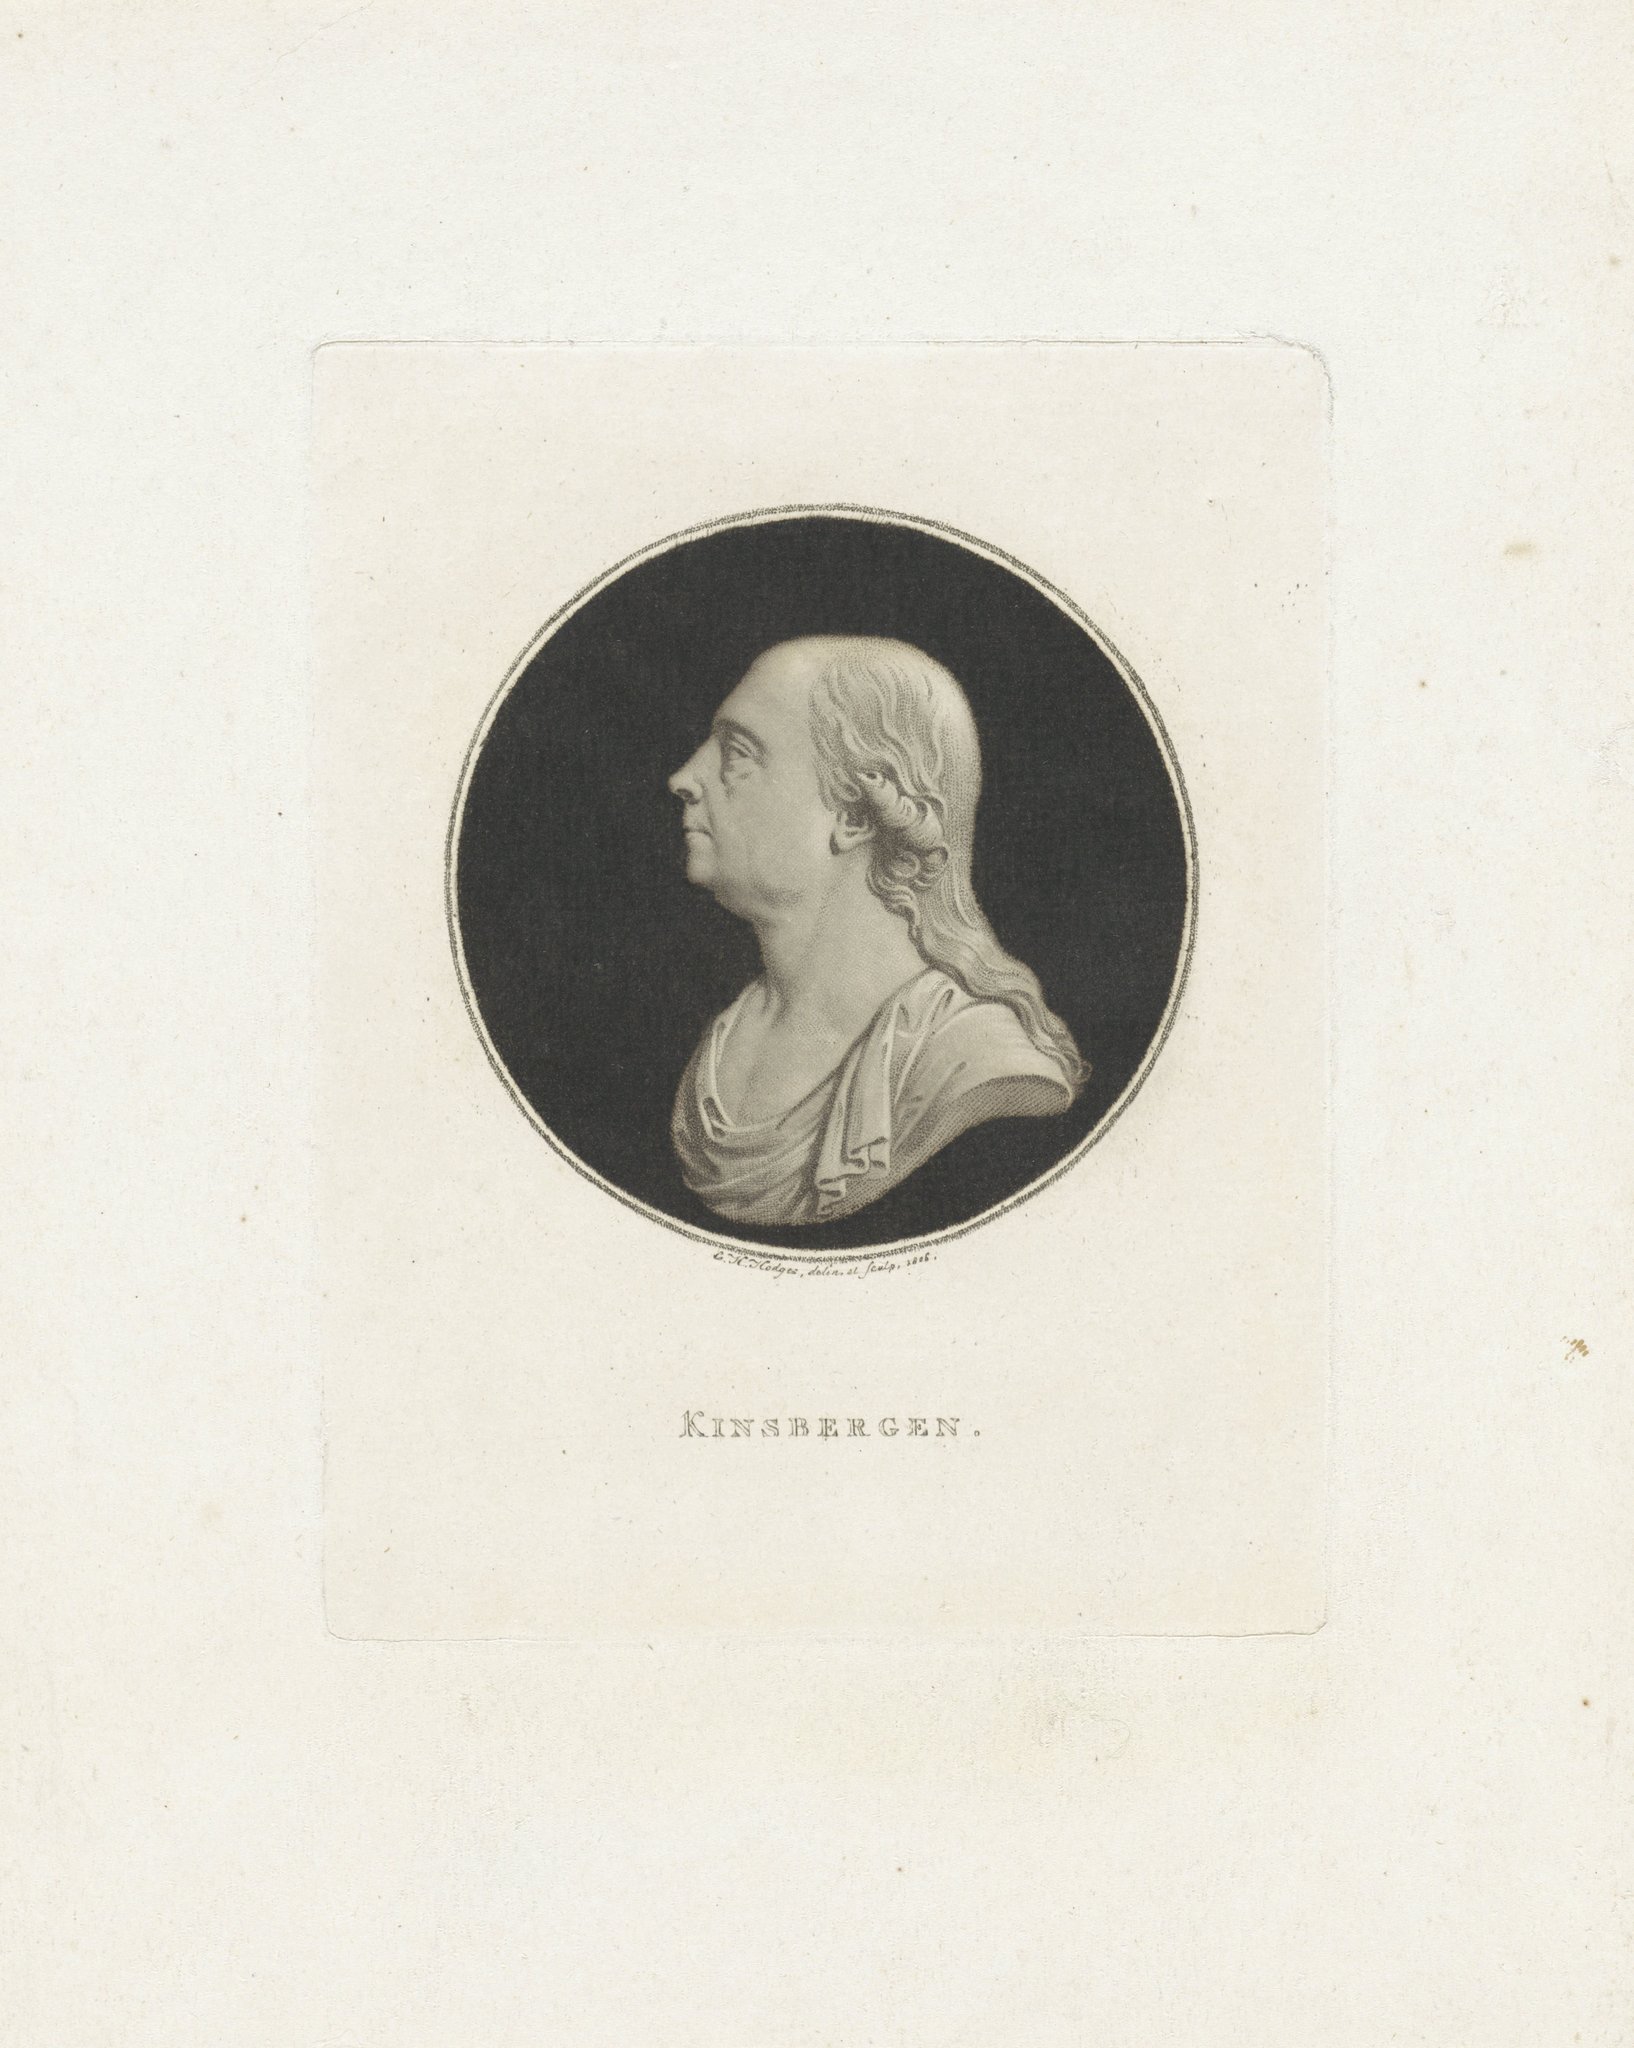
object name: print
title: Portretbuste van admiraal Jan Hendrik van Kinsbergen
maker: charles howard hodges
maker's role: draughtsman, painter, print maker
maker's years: 1764-1837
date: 1806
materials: paper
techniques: engraving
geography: netherlands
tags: jonkheer jan hendrik van kinsbergen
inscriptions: collector's mark: Lugt 2228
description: Jan Hendrik van Kinsbergen, vice-admiraal en buitengewoon maarschalk der Hollandse zeemacht, in profiel.